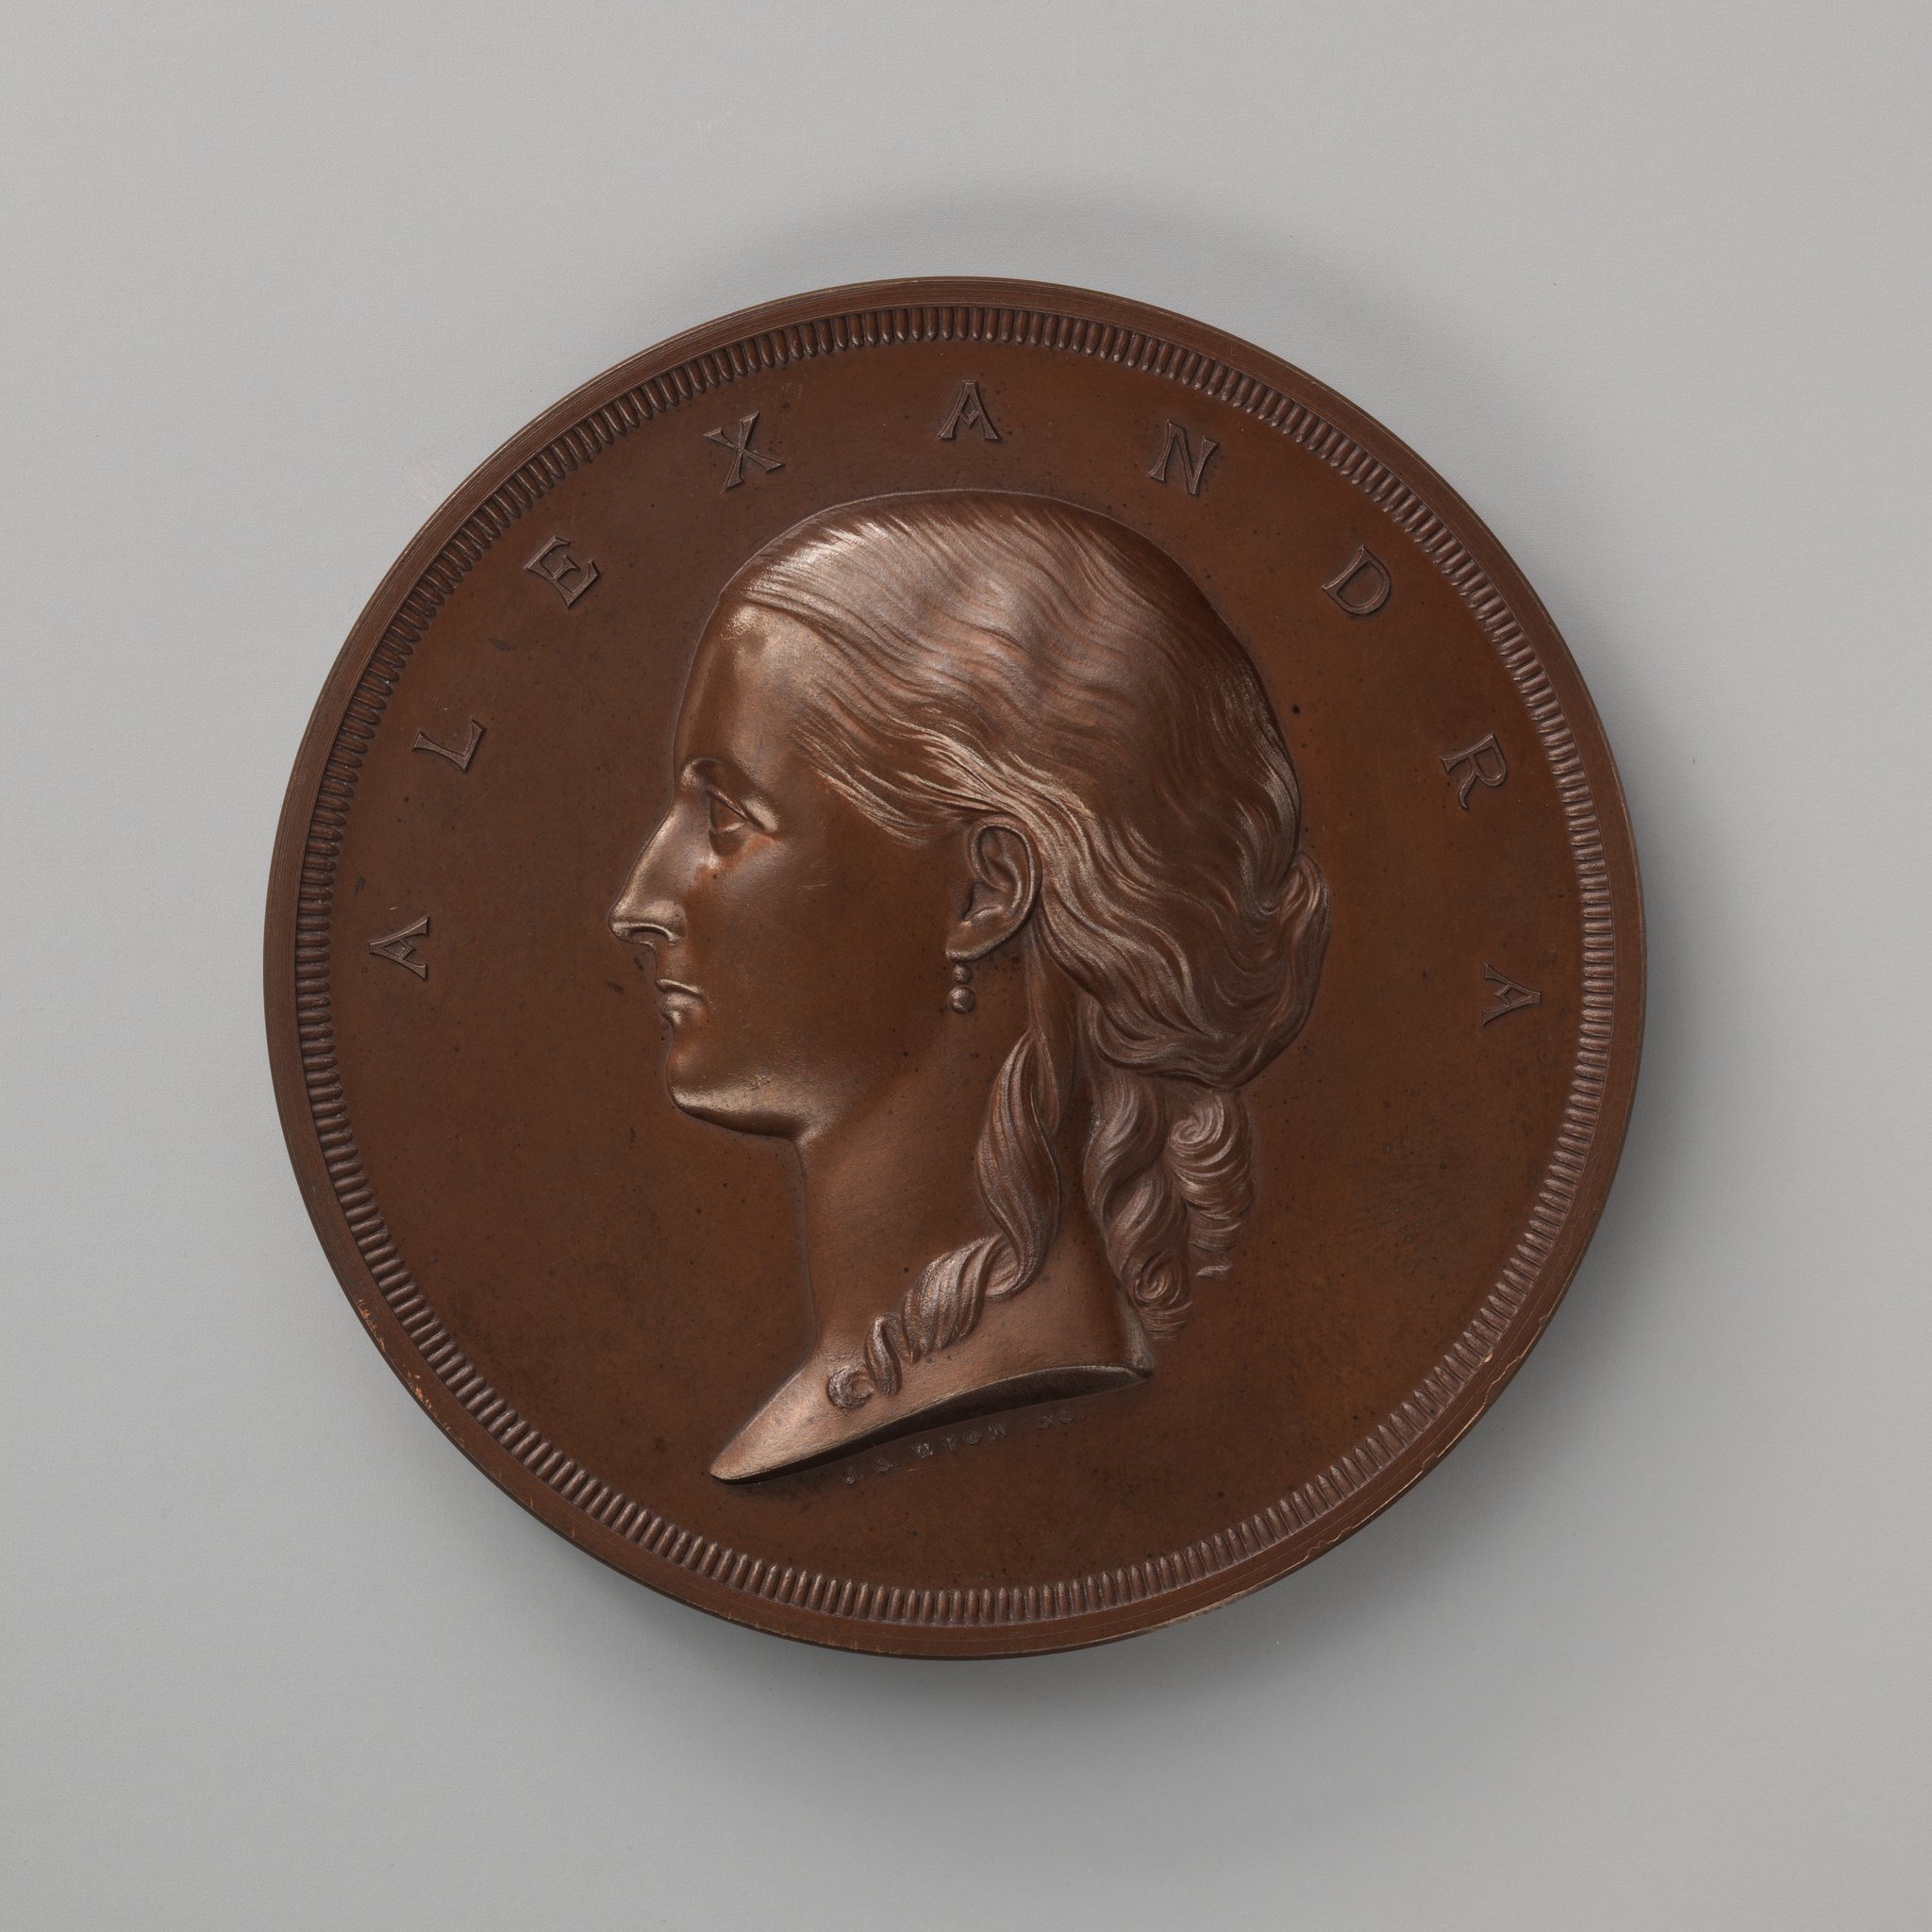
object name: medal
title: To Commemorate the Arrival in London of the Princess Alexandra of Denmark to Wed Albert Edward, Prince of Wales (Edward VII) in March, 1863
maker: alfred benjamin wyon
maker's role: artist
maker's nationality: british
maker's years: 1837-1884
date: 1863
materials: bronze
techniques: struck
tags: princesses,profiles,women